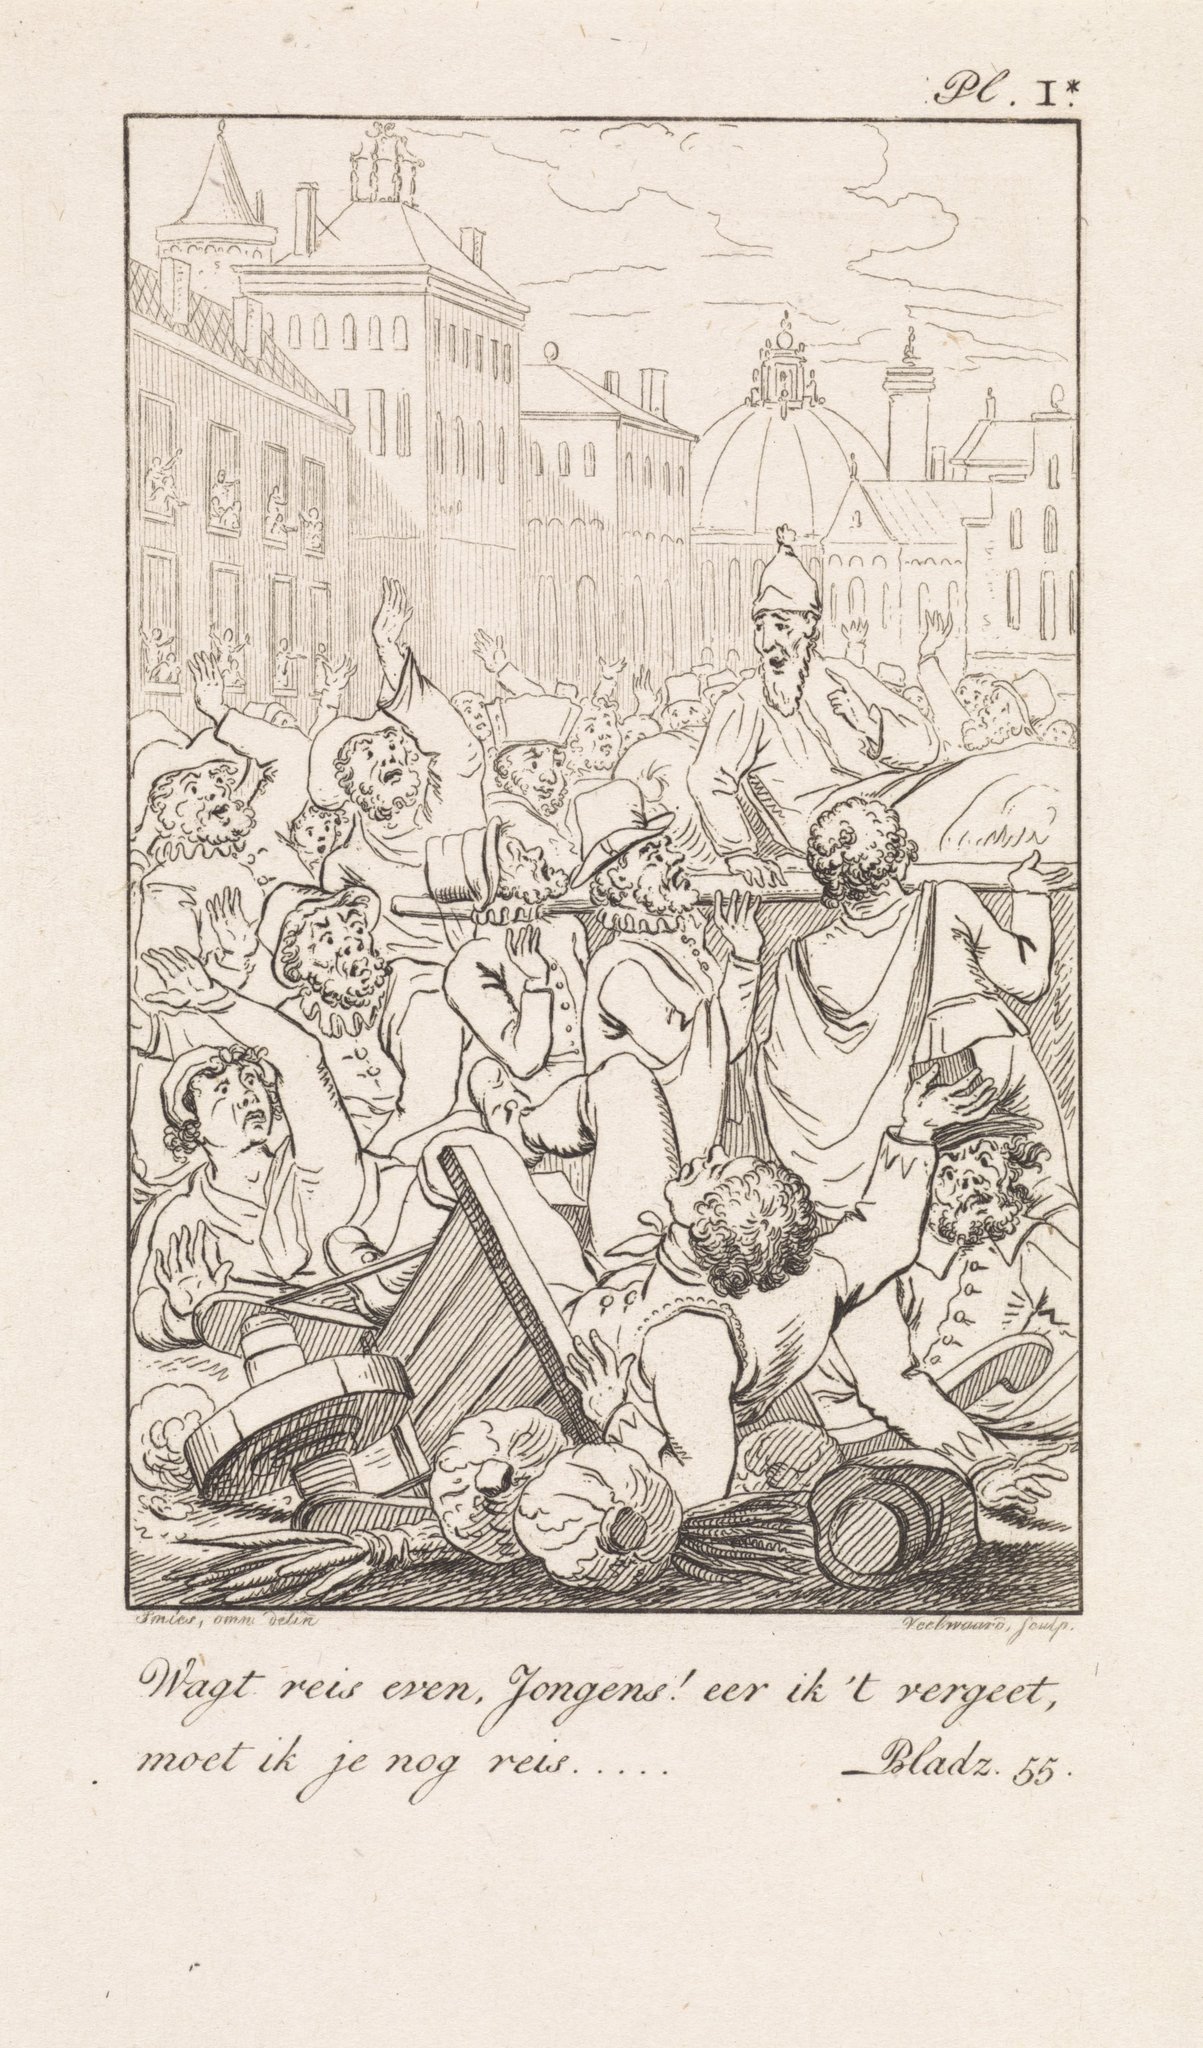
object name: print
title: Sprekende figuur op een baar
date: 1802-1809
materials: paper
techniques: etching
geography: haarlem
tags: political caricatures and satires, paris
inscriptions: collector's mark: Lugt 2228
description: Prent als boekillustratie gebruikt in: Fokke Simonsz., Arend. Het hoekjen van den haard of Historie van Frankrijk. Deel IV-VII uit: Boertige Reis door Europa. 7 dln. Haarlem: François Bohn, 1802-1809.